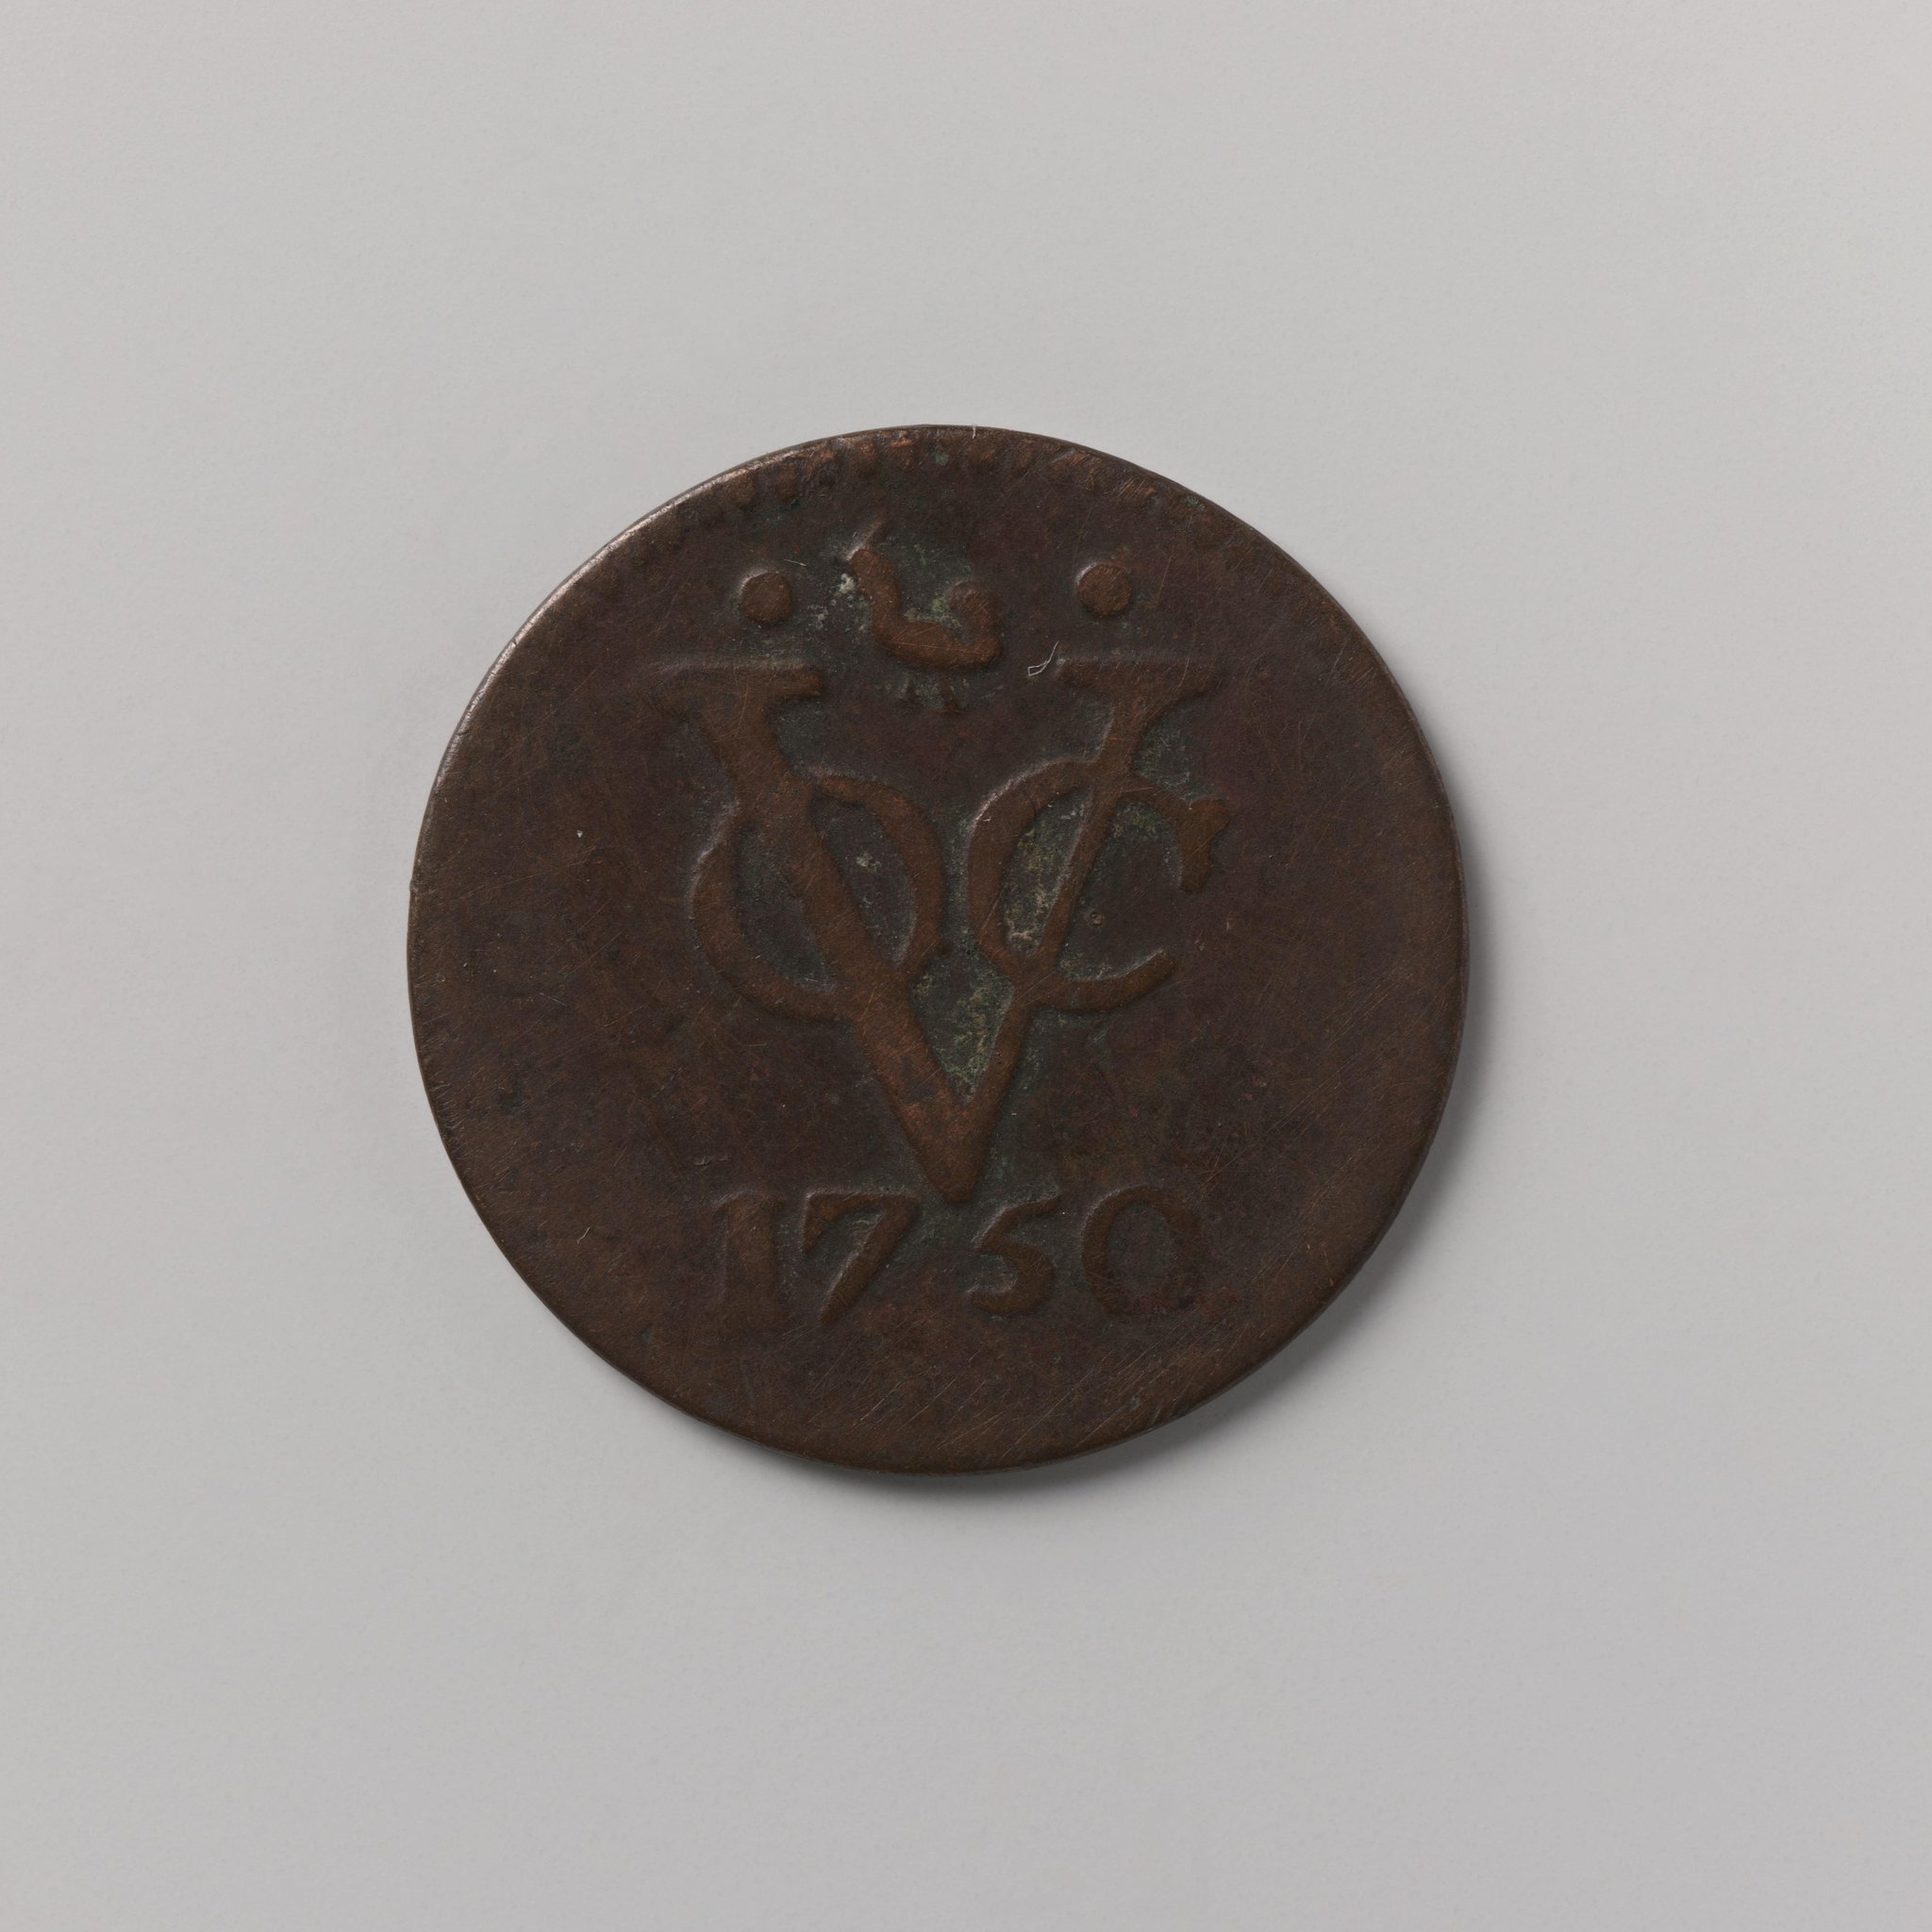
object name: coin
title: Duit van de VOC uit Westfriesland, 1750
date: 1750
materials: copper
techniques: striking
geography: medemblik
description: Koperen munt. Voorzijde: gekroond wapenschild van Westfriesland. Keerzijde: monogram van de VOC, waarboven muntmeesterteken en waaronder jaartal. Gladde rand.